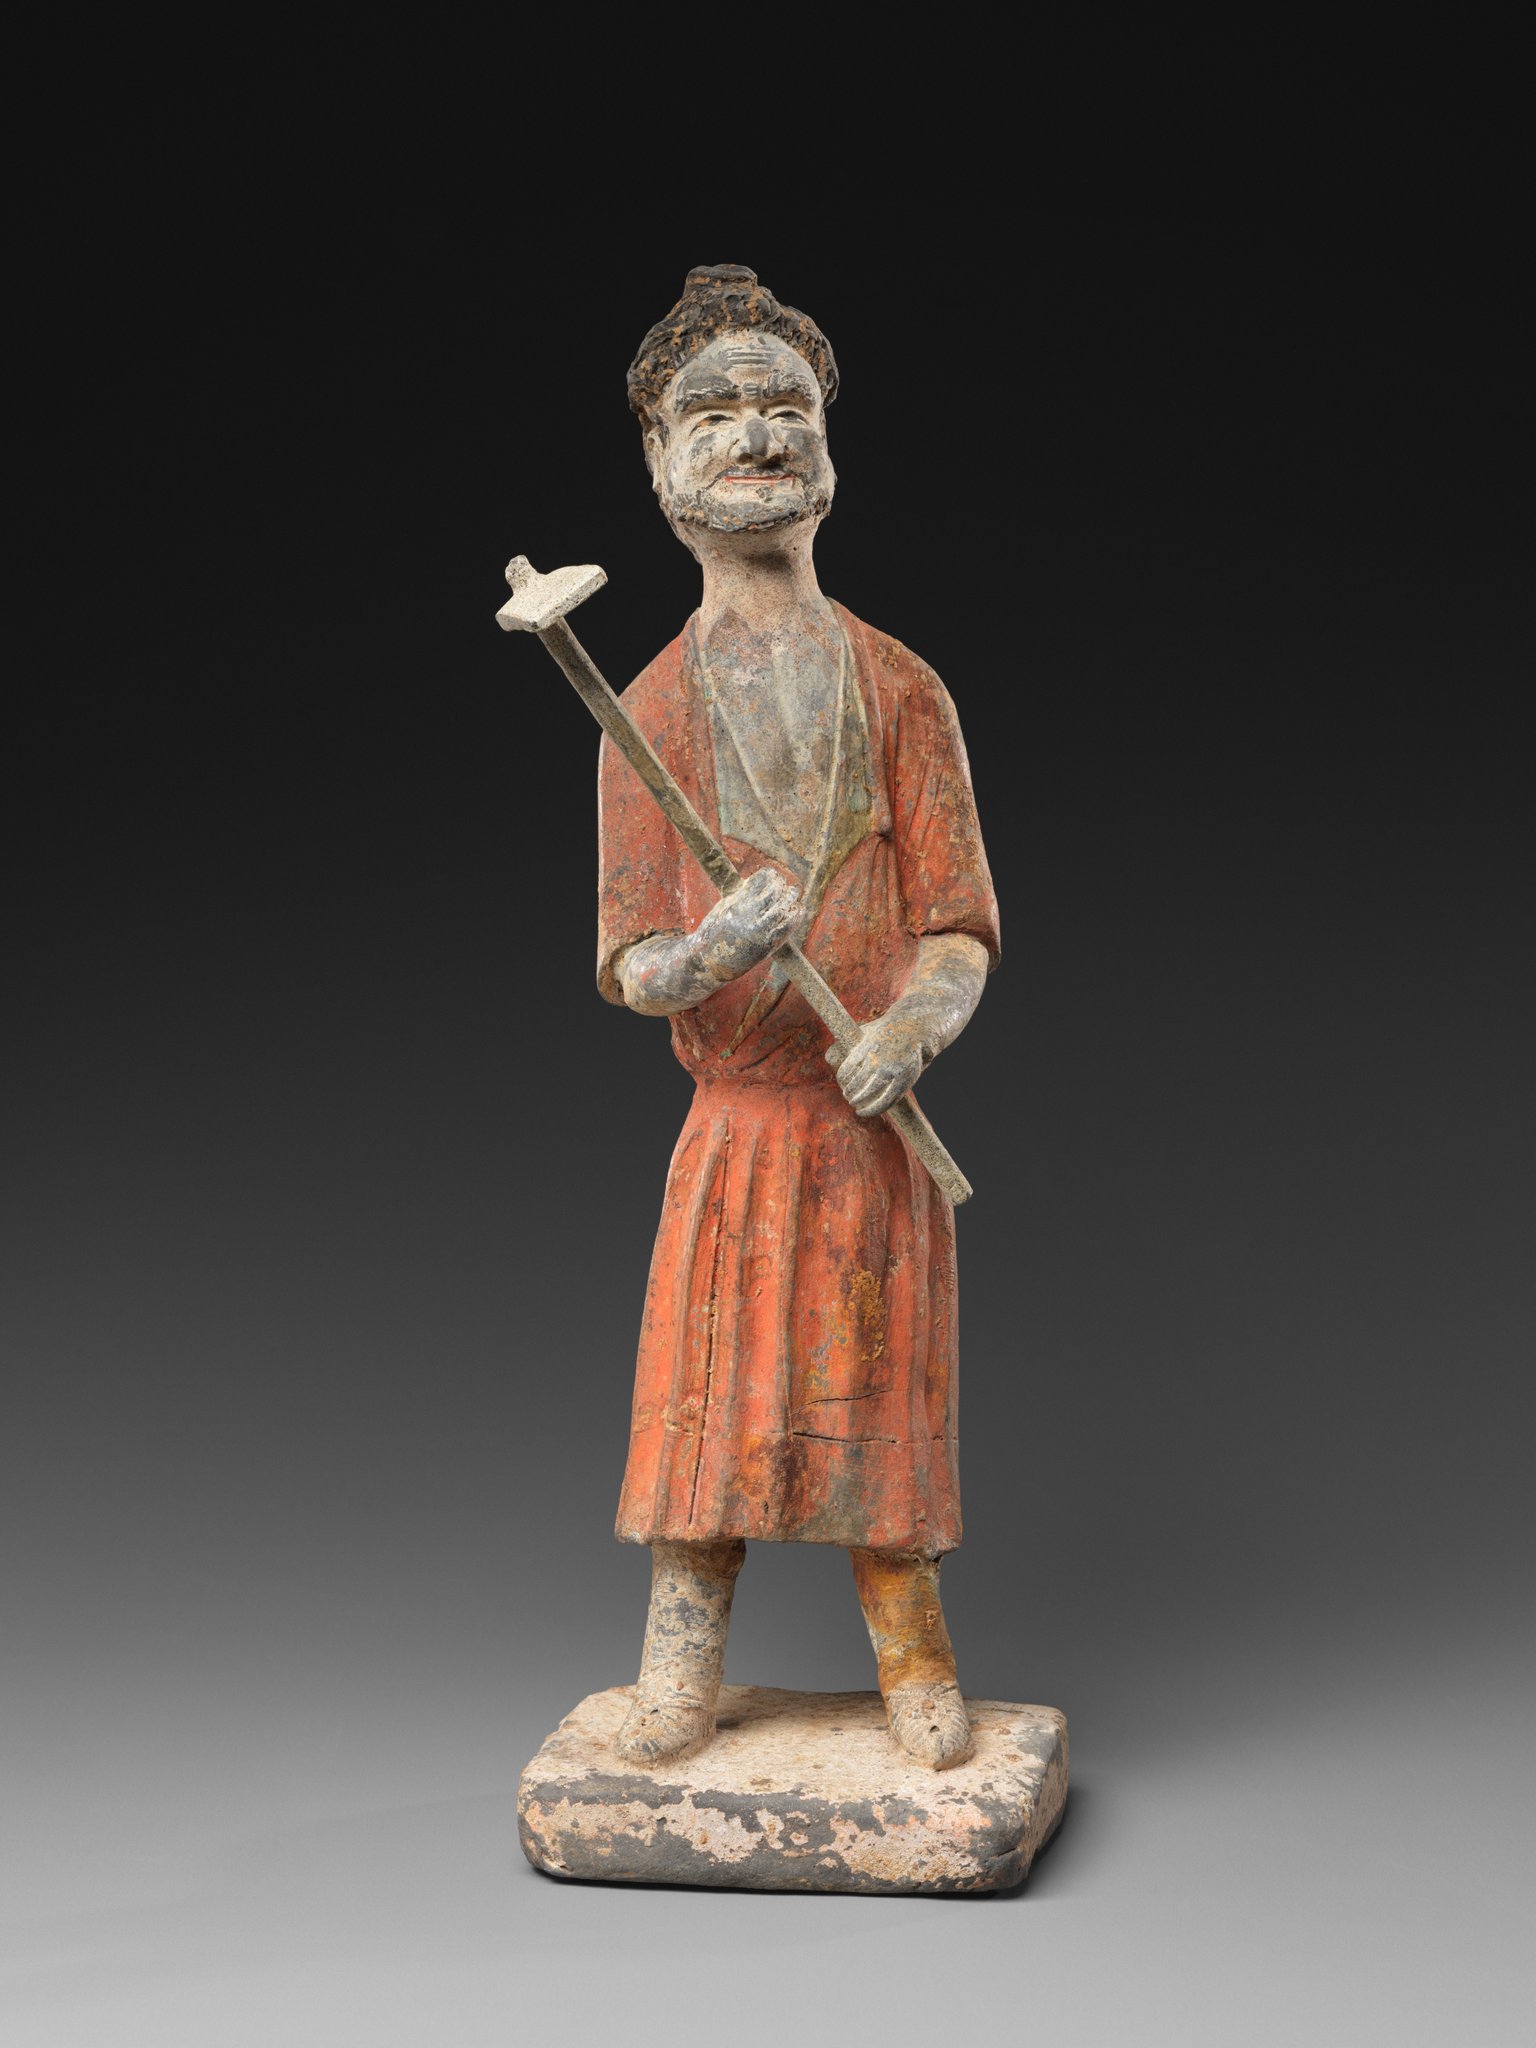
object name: figure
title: Man with a hoe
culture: chinese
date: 601-700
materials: earthenware, pigment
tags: men